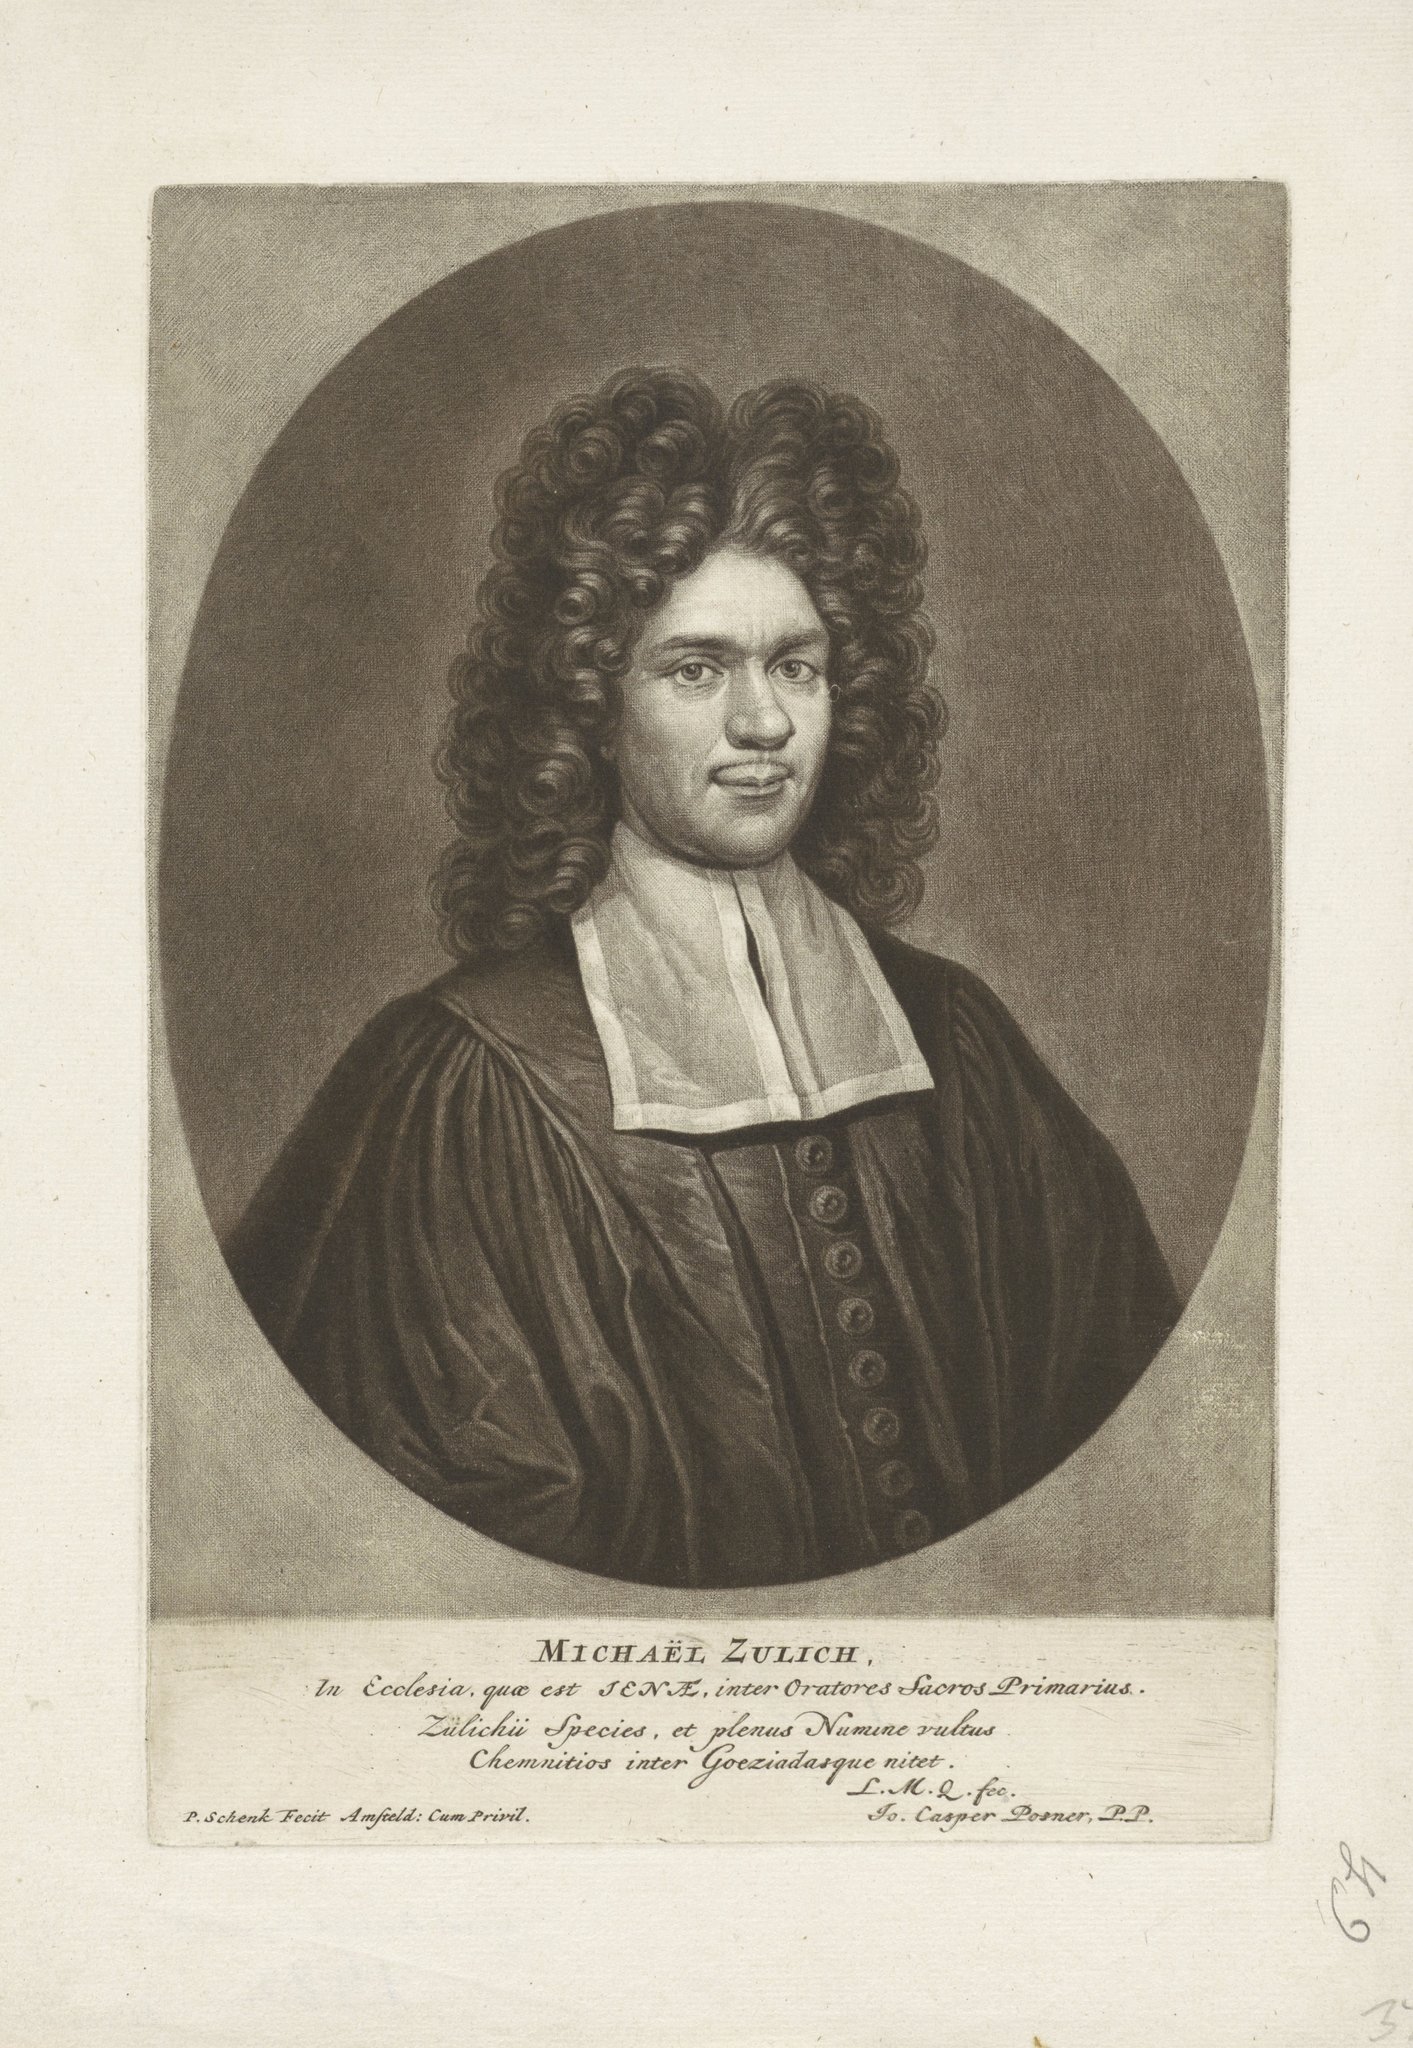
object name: print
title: Portret van de predikant Michael Zulich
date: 1670-1713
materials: paper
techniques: engraving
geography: amsterdam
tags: predikant, michael zulich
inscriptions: collector's mark: Lugt 2228